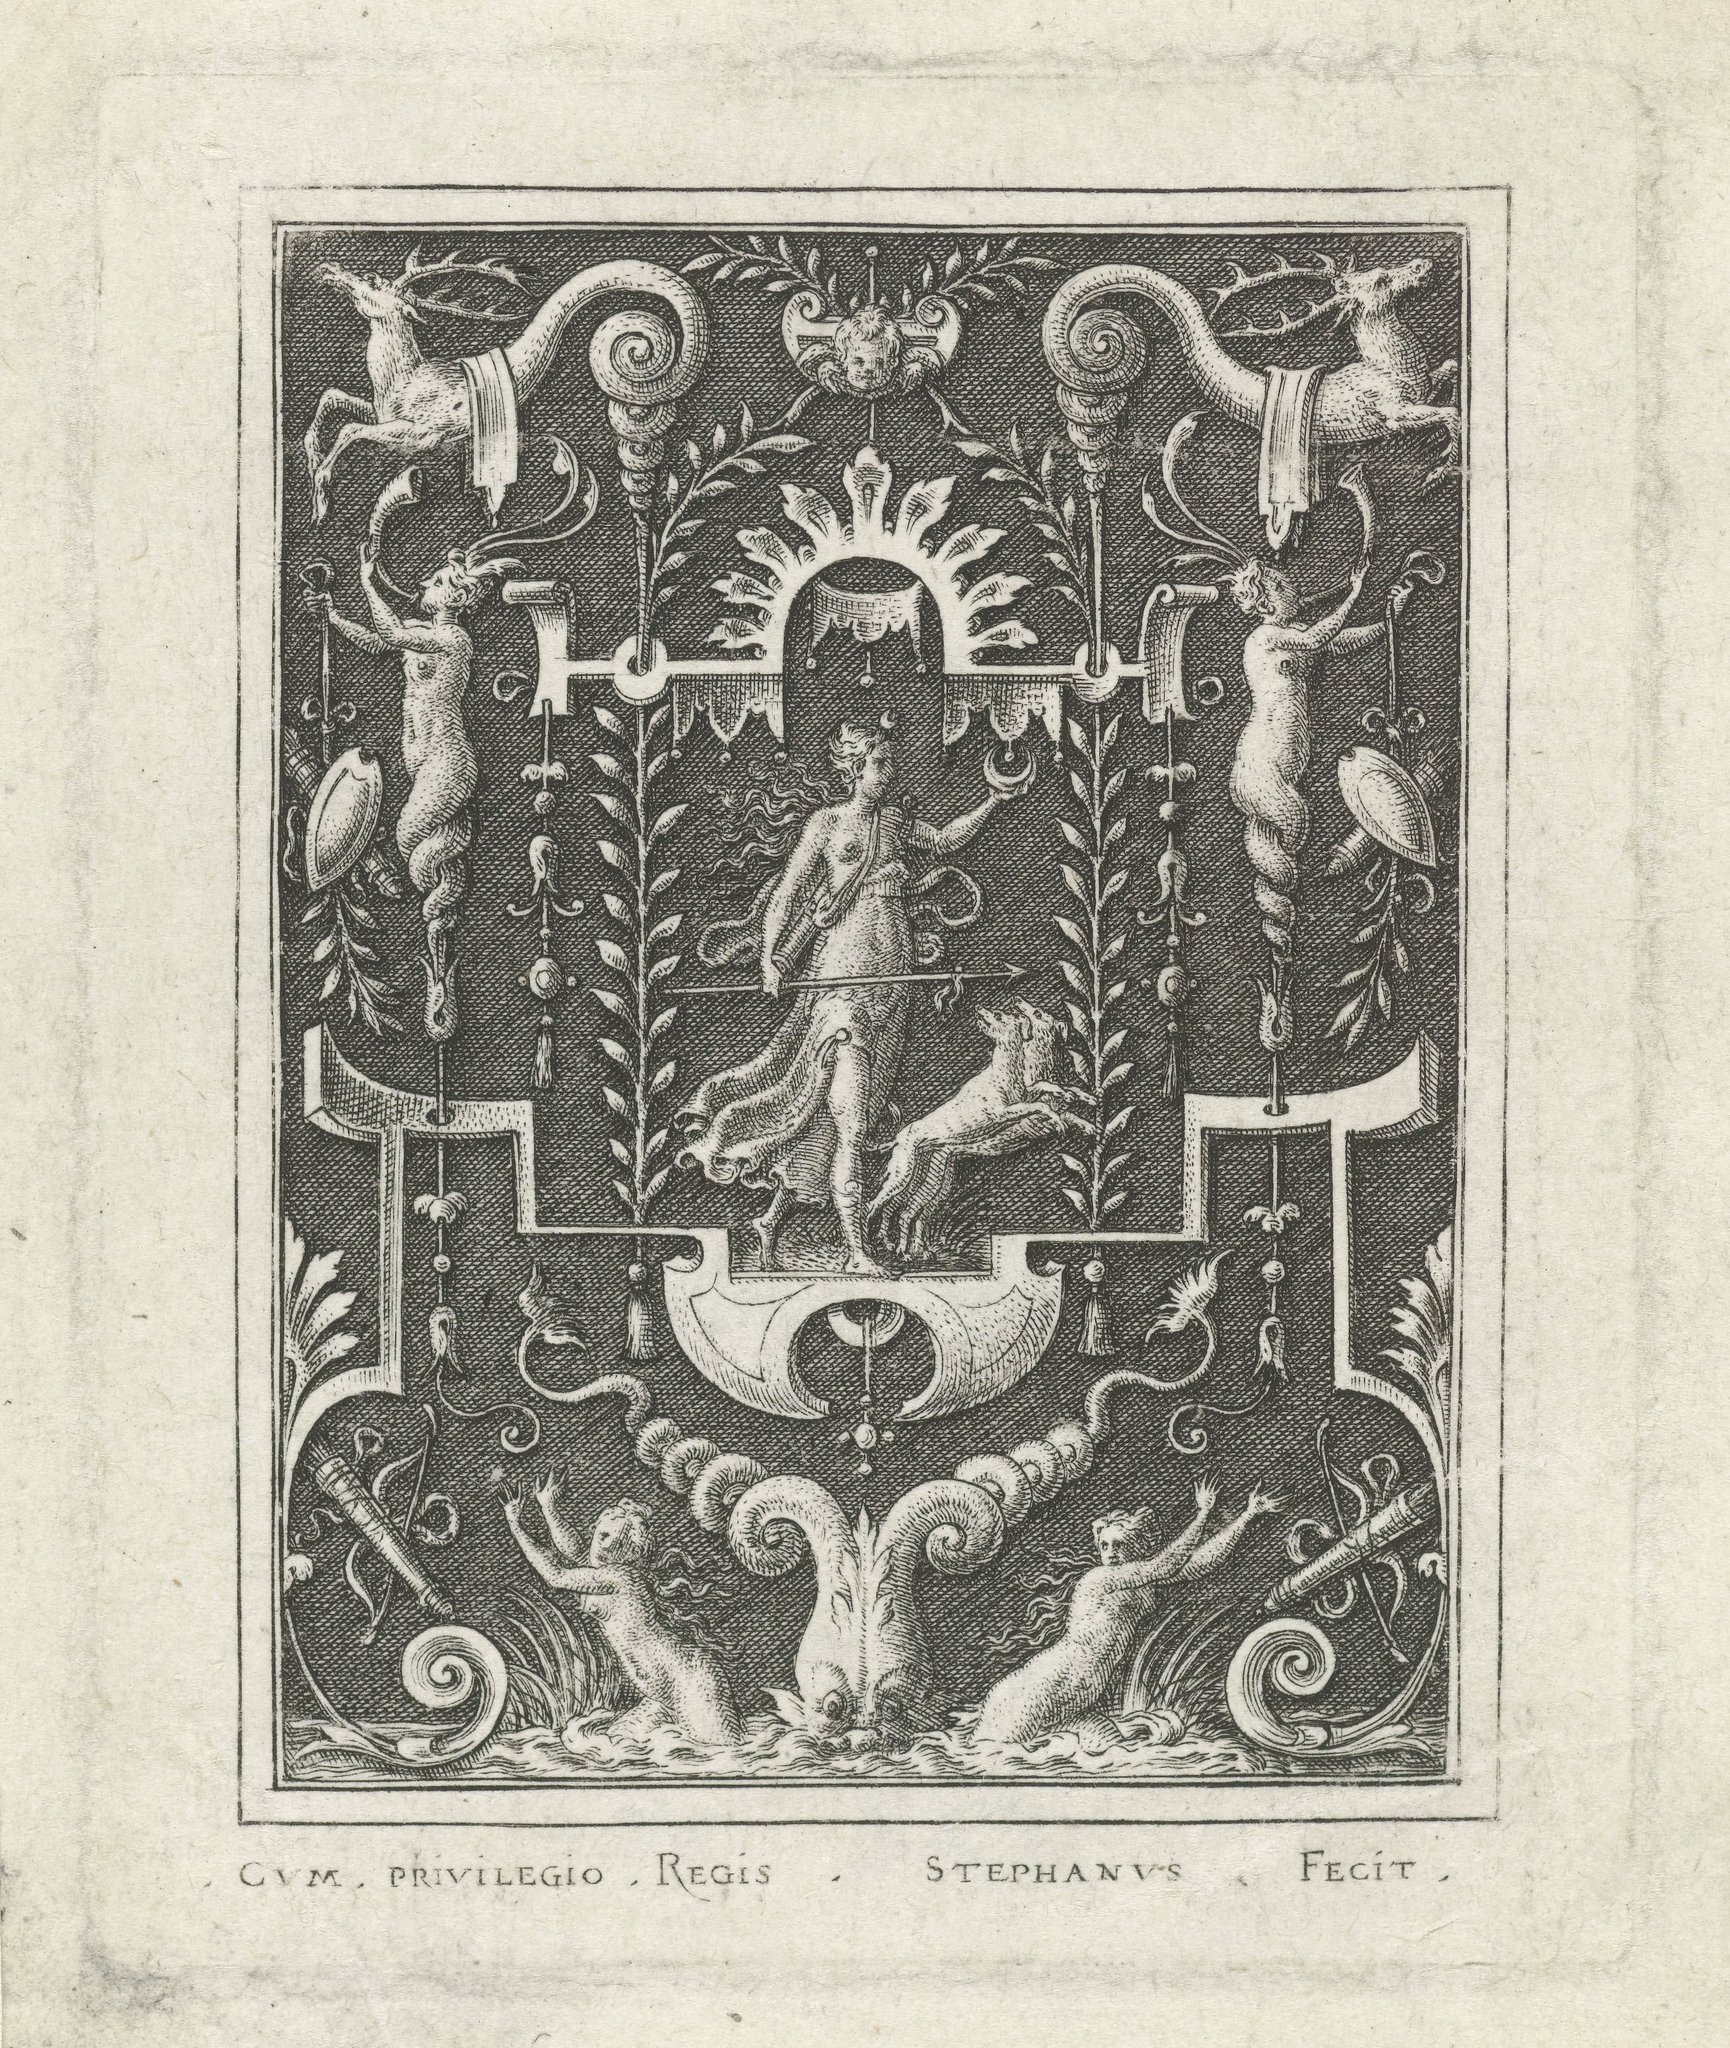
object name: ornament print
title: Vlakdecoraties met godenfiguren in een omlijsting van grotesken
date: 1528-1583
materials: paper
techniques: engraving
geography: france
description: Diana, met de maansikkel in de hand, geflankeerd door twee hermen met dubbele, in elkaar gedraaide staarten. Uit serie van 6 bladen.